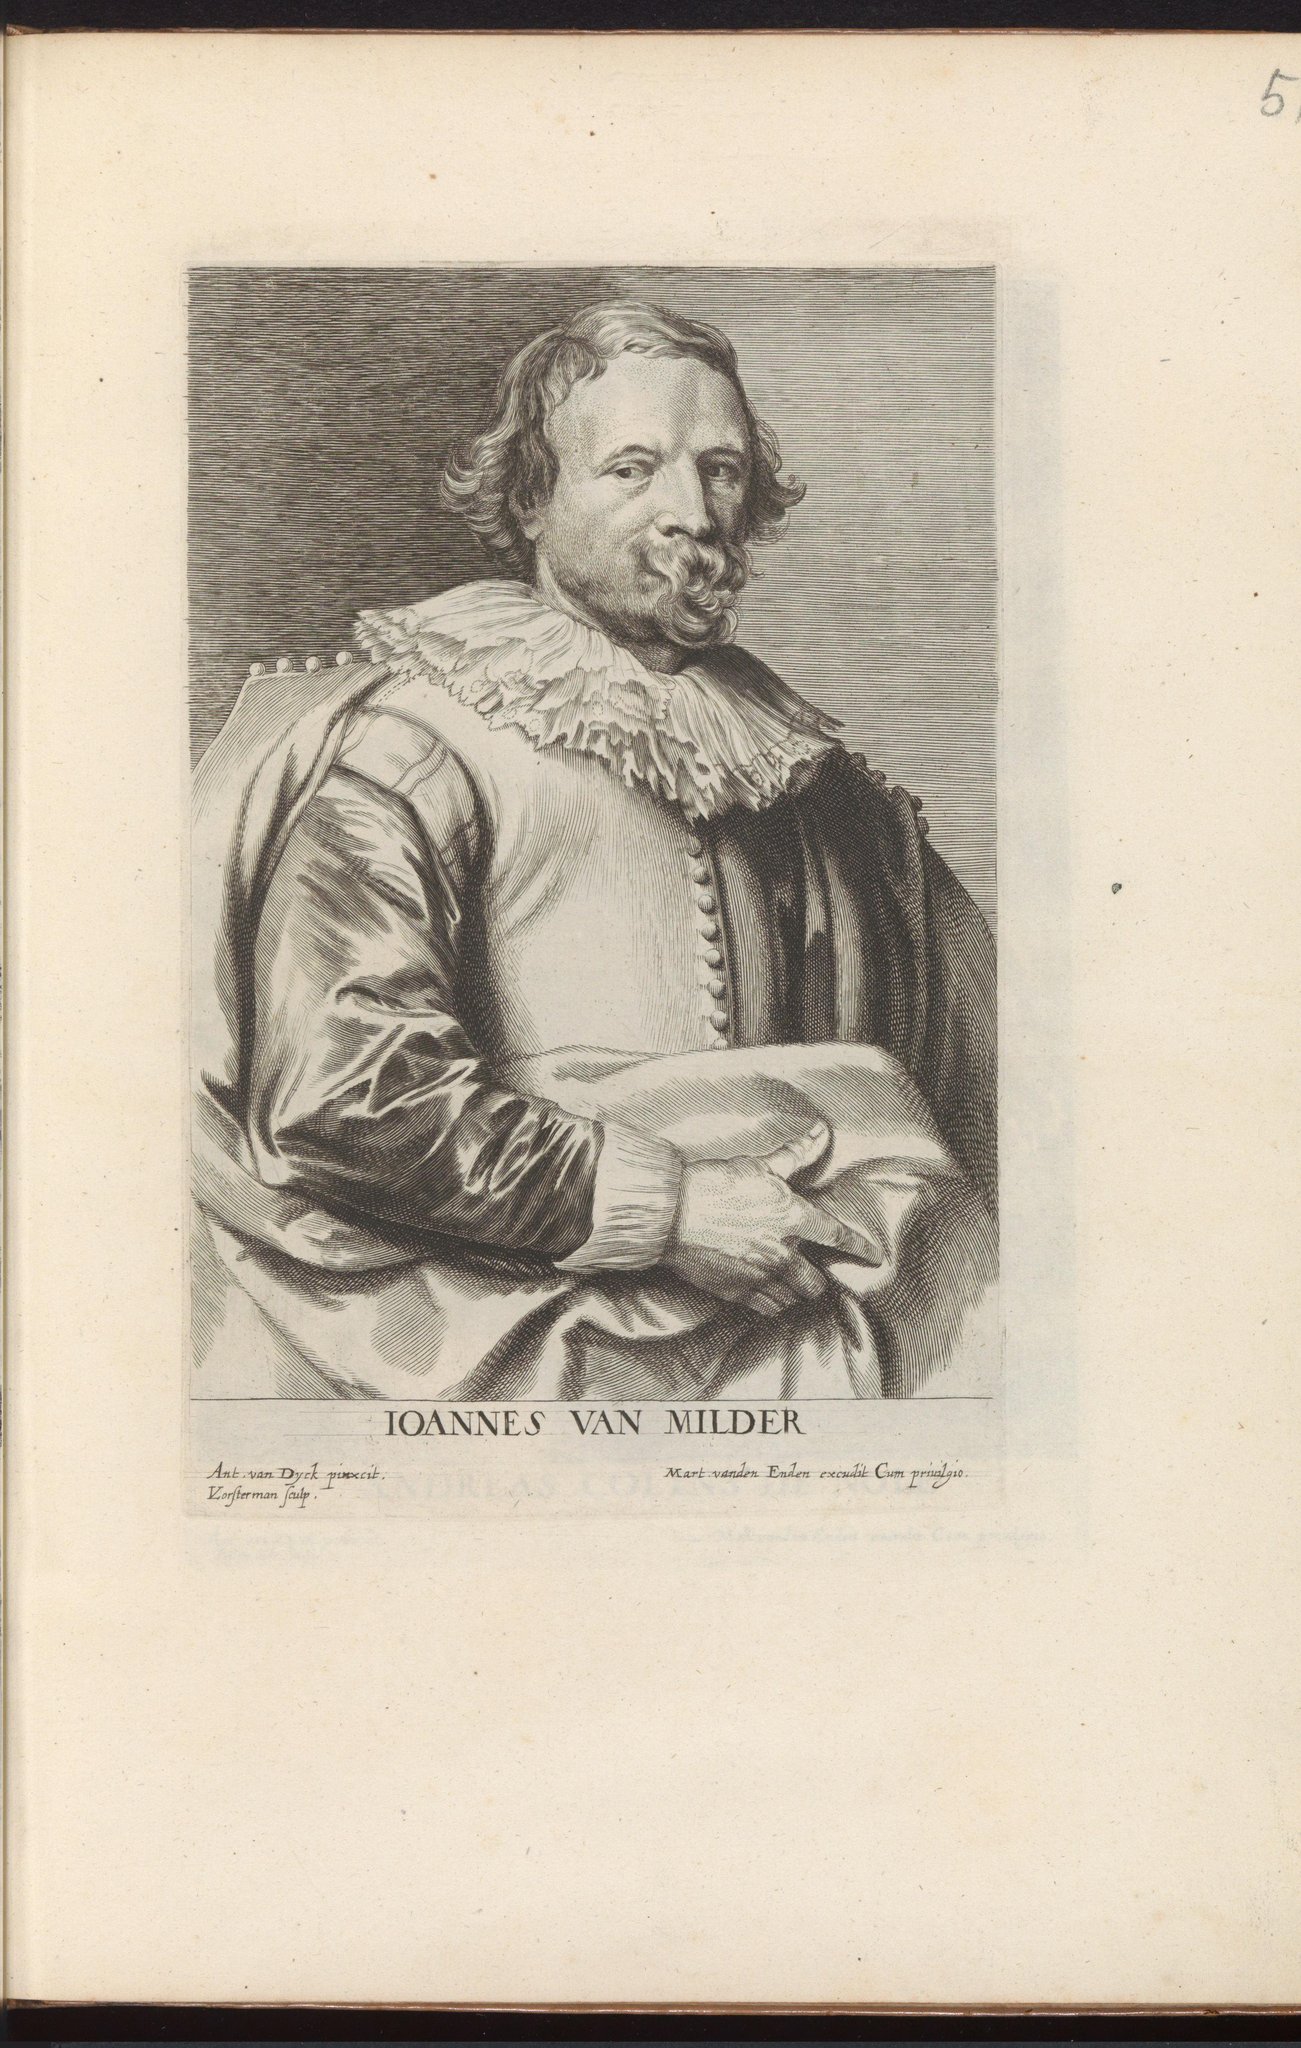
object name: print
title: Icones Principum Vivorum Doctorum Pictorum Chalcographorum Statuariorum nec non Amatorum Pictoriae Artis Numero Centum ab Antonio van Dyck Pictore ad Vivum Expressae Eiusq: Sumptibus aeri incisae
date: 1630-1641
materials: paper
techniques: engraving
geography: antwerp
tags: antwerp, sculptor, johannes van mildert, portrait, self-portrait of sculptor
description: Portret van de Antwerpse beeldhouwer Johannes van Mildert. Deze prent maakt deel uit van een album.